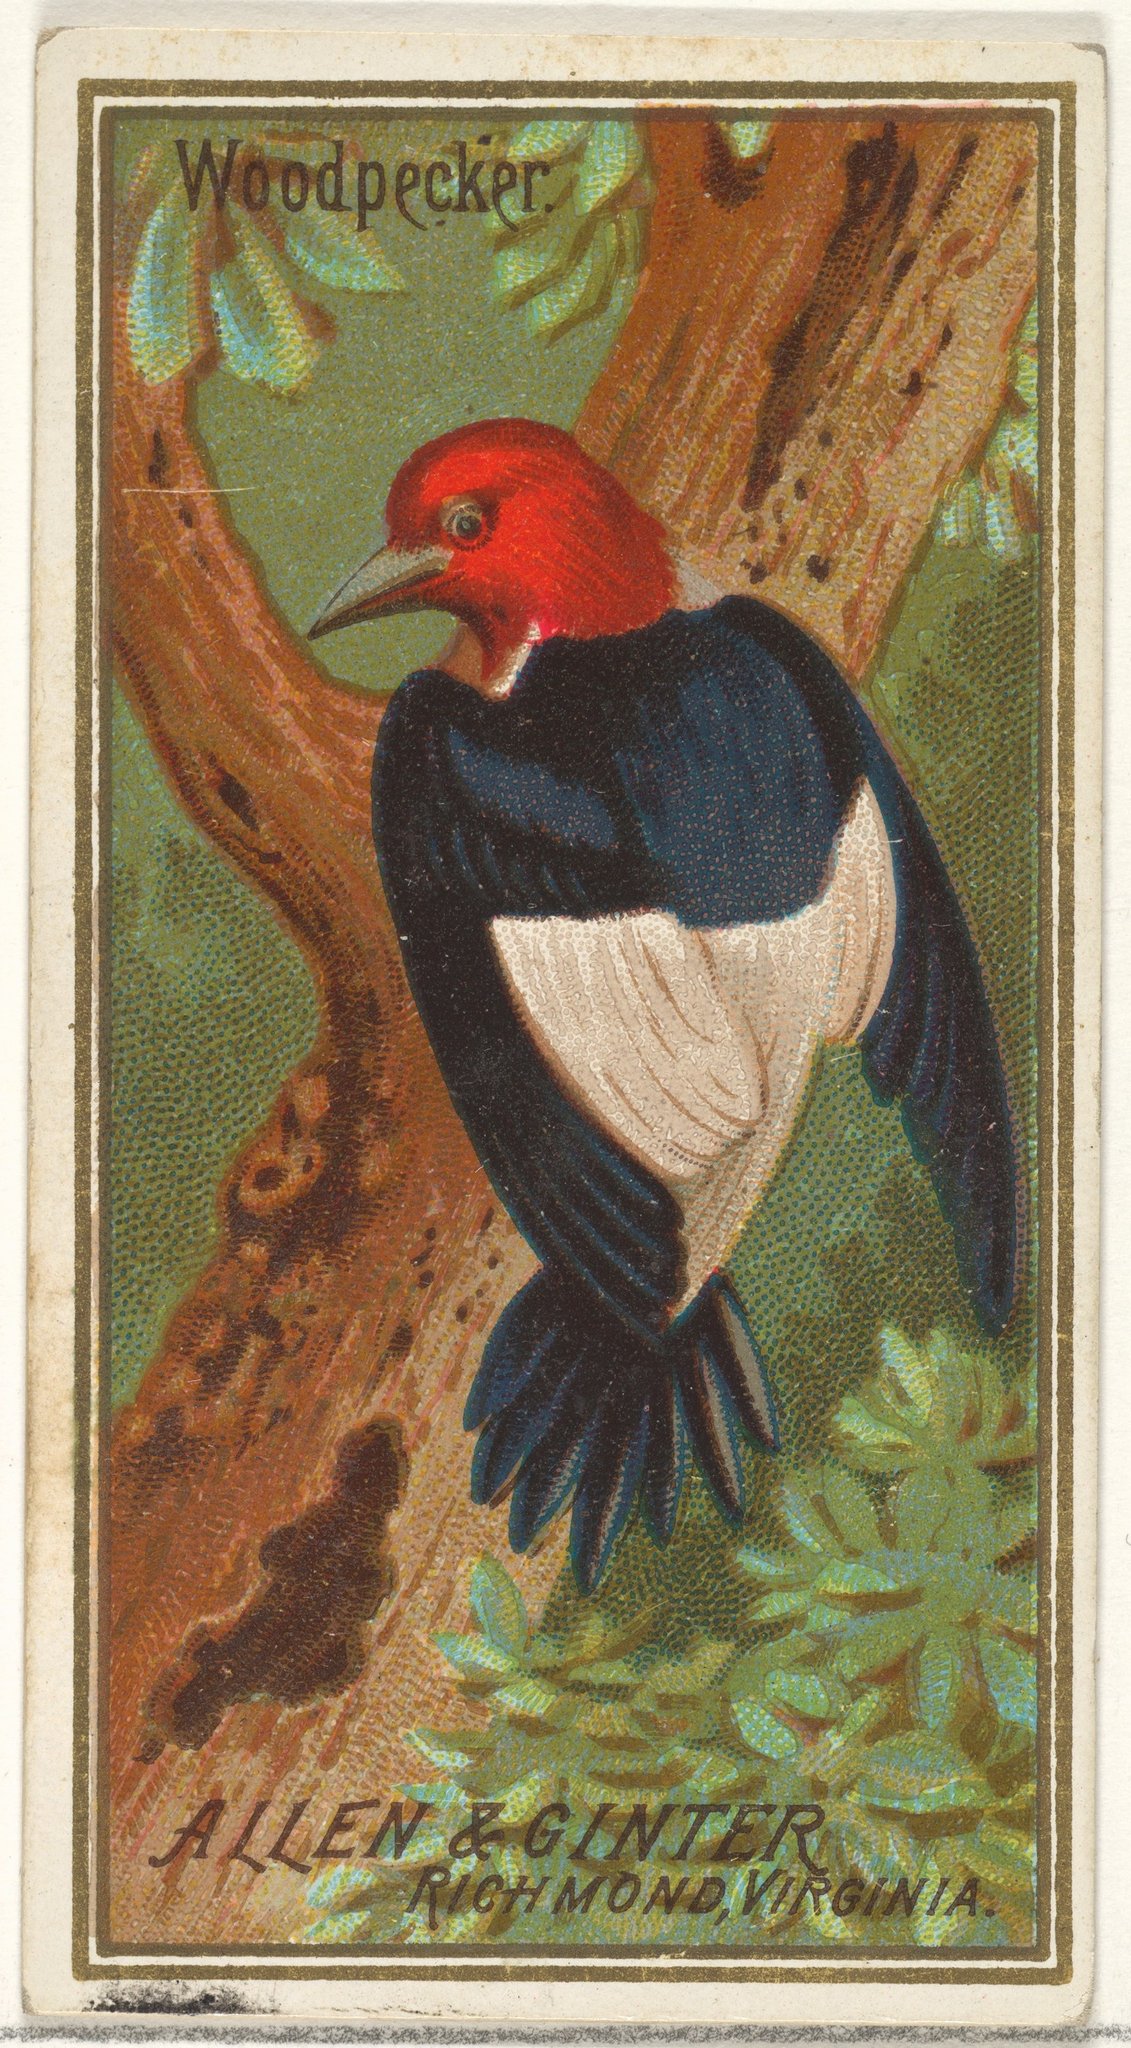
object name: print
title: Woodpecker, from the Birds of America series (N4) for Allen & Ginter Cigarettes Brands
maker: allen & ginter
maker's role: publisher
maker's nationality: american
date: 1888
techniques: color lithograph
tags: birds